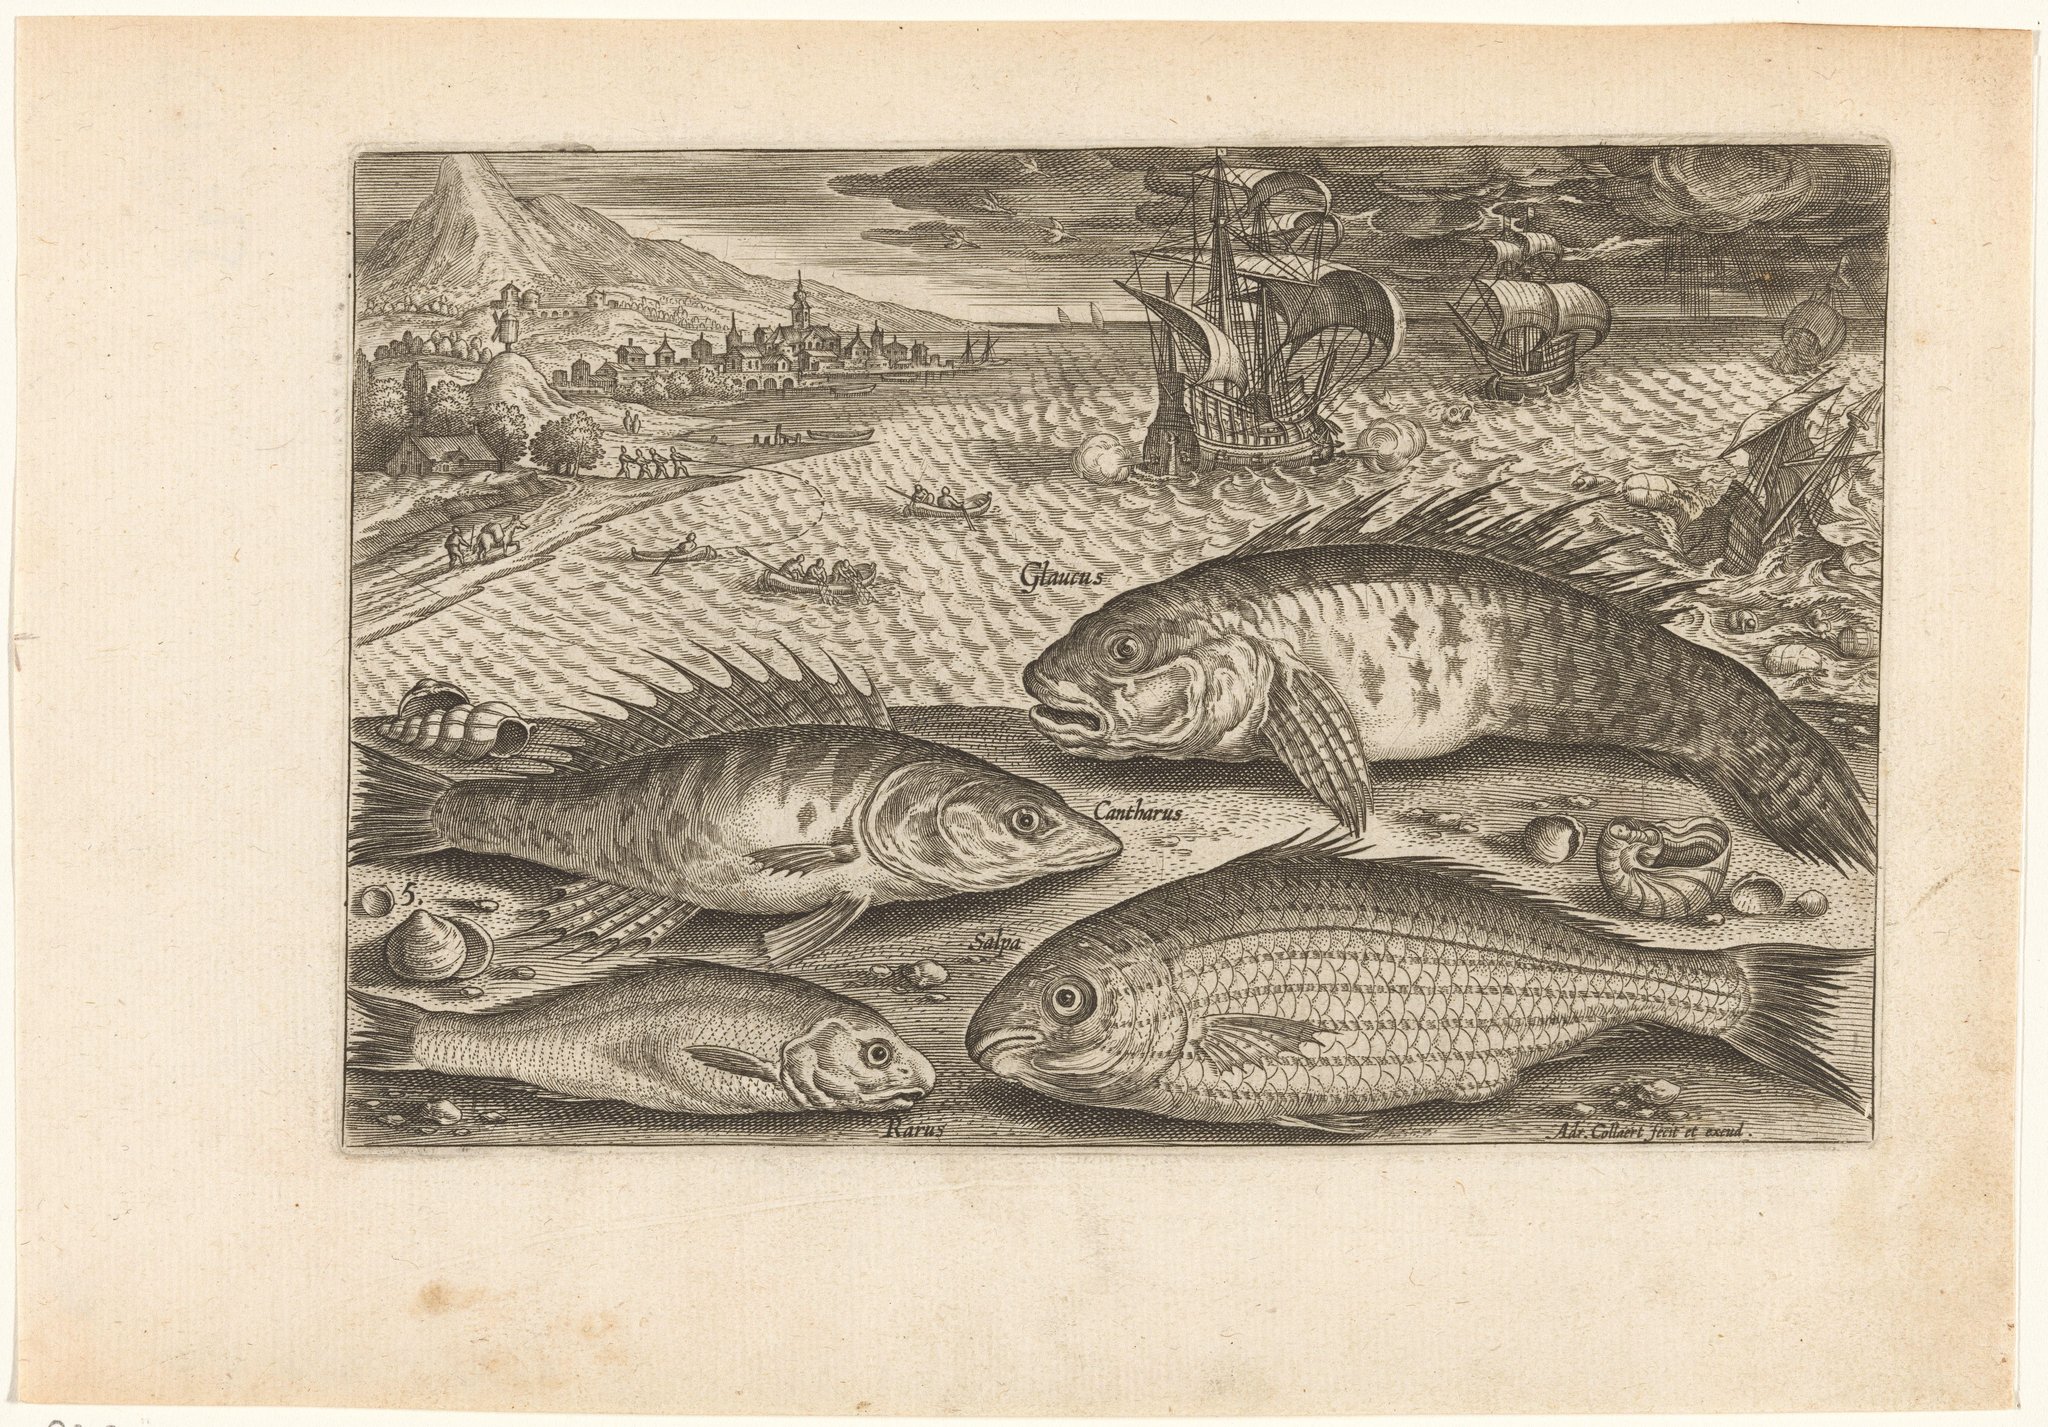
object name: print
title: Vissen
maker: adriaen collaert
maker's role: draughtsman, print maker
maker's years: 1560-1618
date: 1598-1618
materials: paper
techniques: engraving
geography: antwerp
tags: sea (seascape), bony fishes: sea-bream, bony fishes: salpa, bony fishes: goby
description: Een bokvis, een baars, een grondel en een onbekende vis liggen samen met wat schelpen aangespoeld op het strand. Op de achtergrond de zee met wat schepen. De prent maakt deel uit van een serie met vissen als onderwerp.